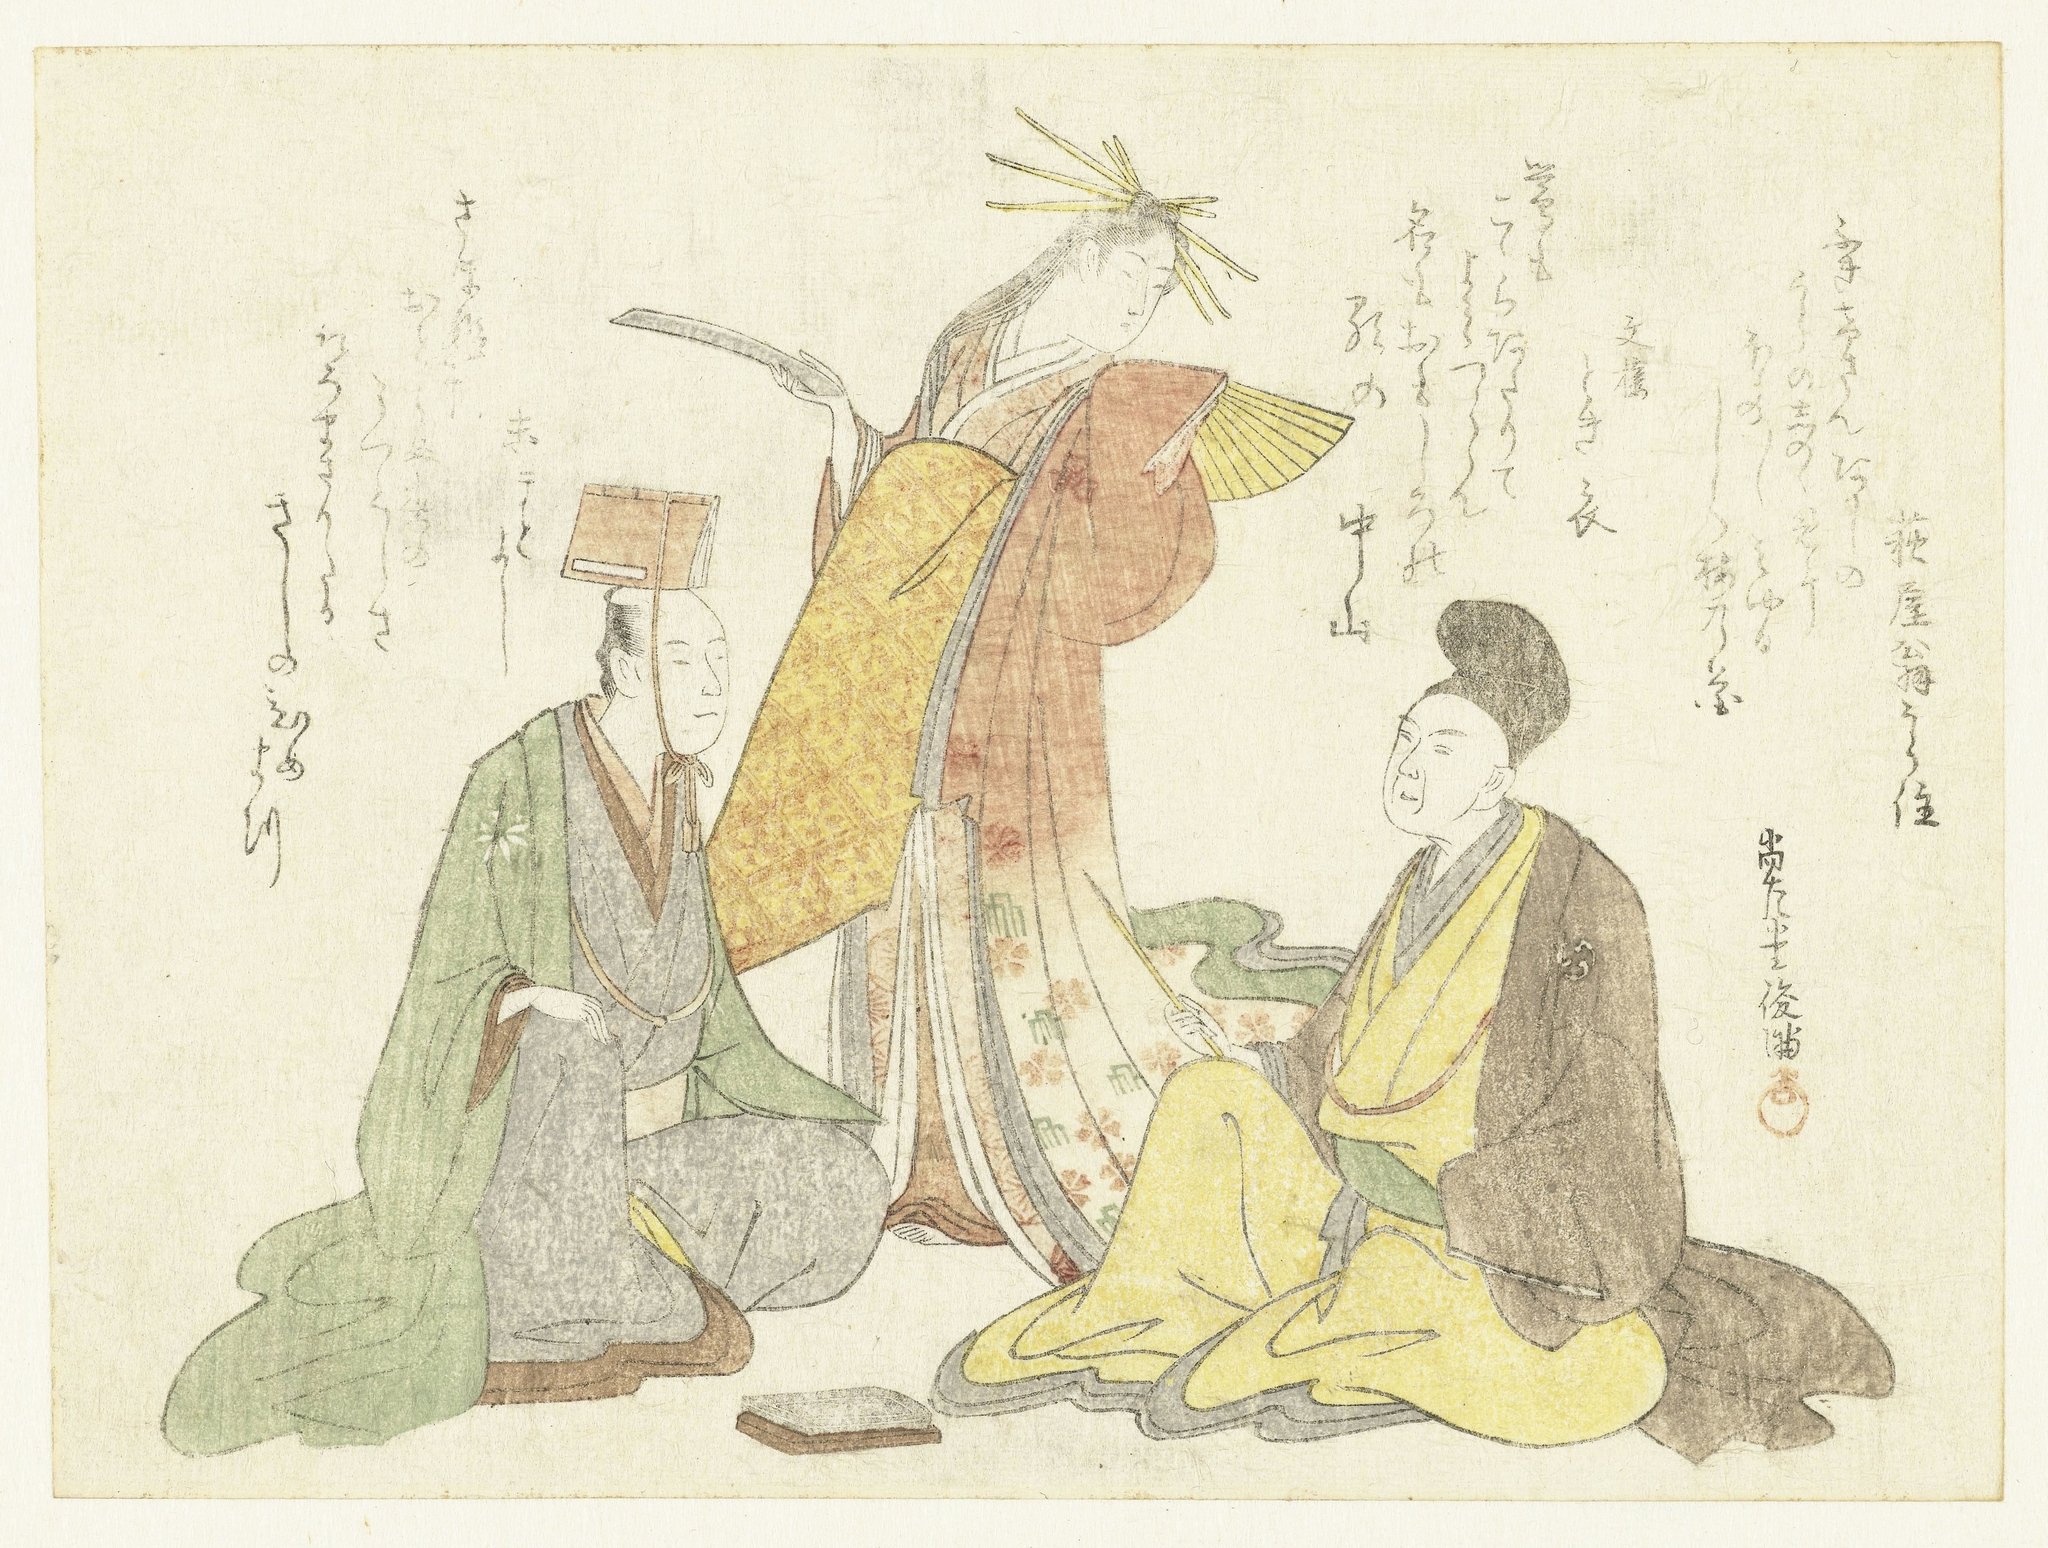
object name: print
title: A Meeting of Three Poets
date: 1799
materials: paper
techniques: woodcut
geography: japan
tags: adult woman, sitting figure (+ two persons), writer, poet, author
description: Een surimono is een luxe uitgevoerde prent waarop beeld met één of meerdere gedichten gecombineerd is. Bij het drukken van een surimono werd vaak gebruik gemaakt van dikker papier, blinddruk en metaal pigmenten, zoals koper- en zilverpoeder. De prenten werden vaak in opdracht van dichters gemaakt en als exclusief geschenk aan vrienden en relaties gegeven.